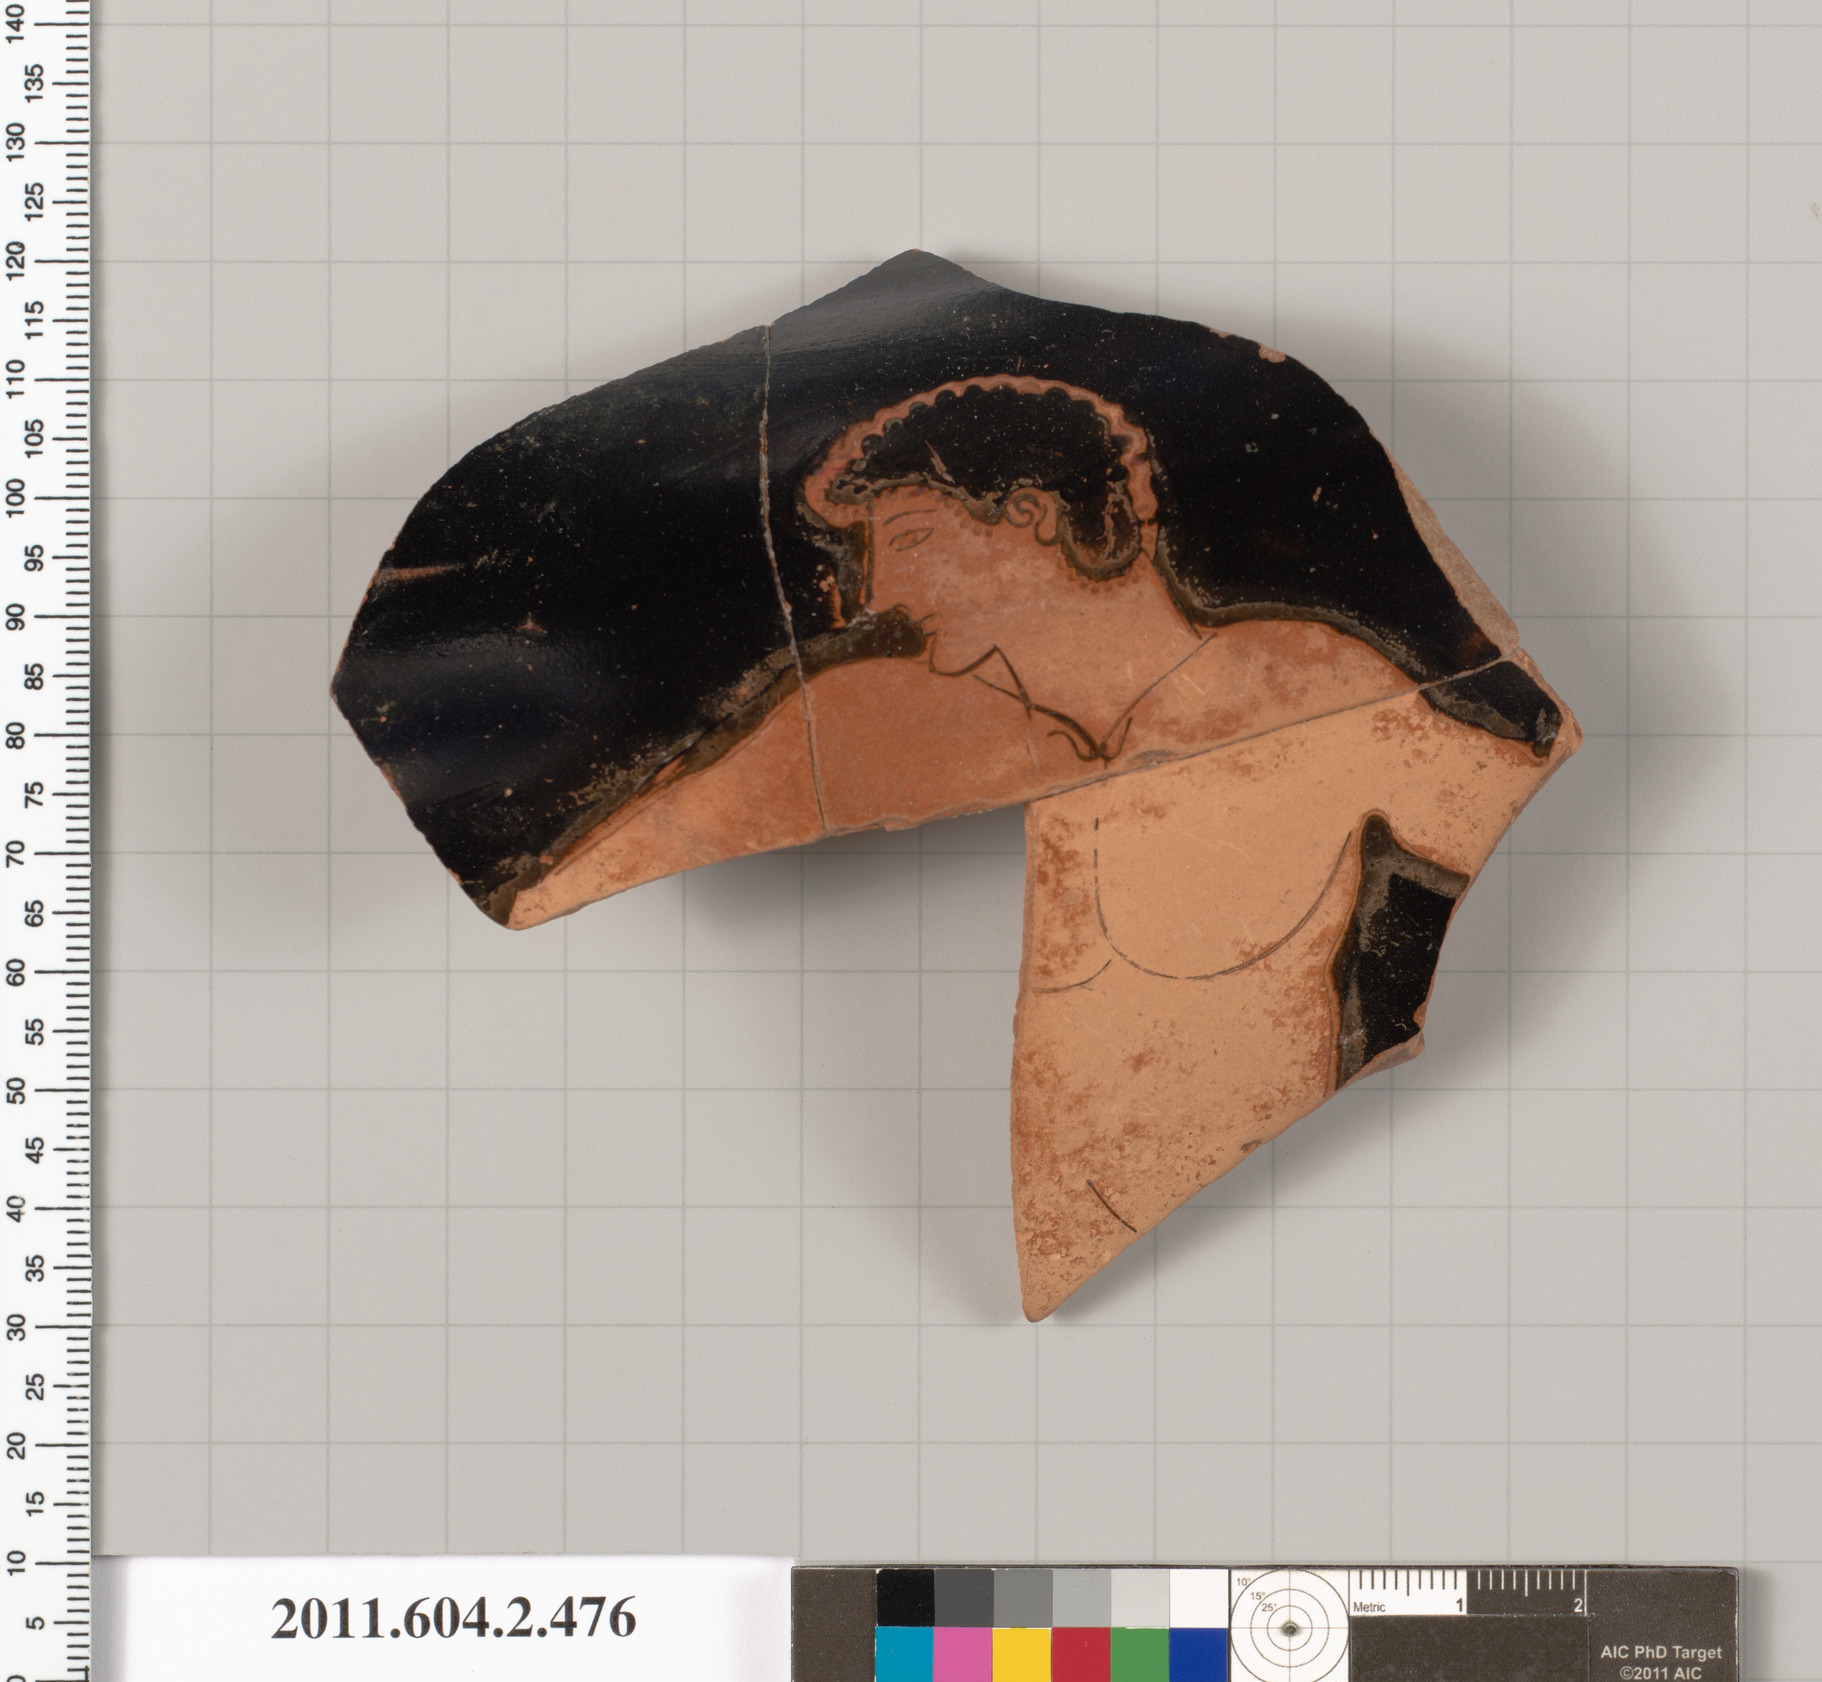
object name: column krater fragment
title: Terracotta fragment of a column-krater (bowl for mixing wine and water)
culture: greek, attic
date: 480-470 BCE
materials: terracotta